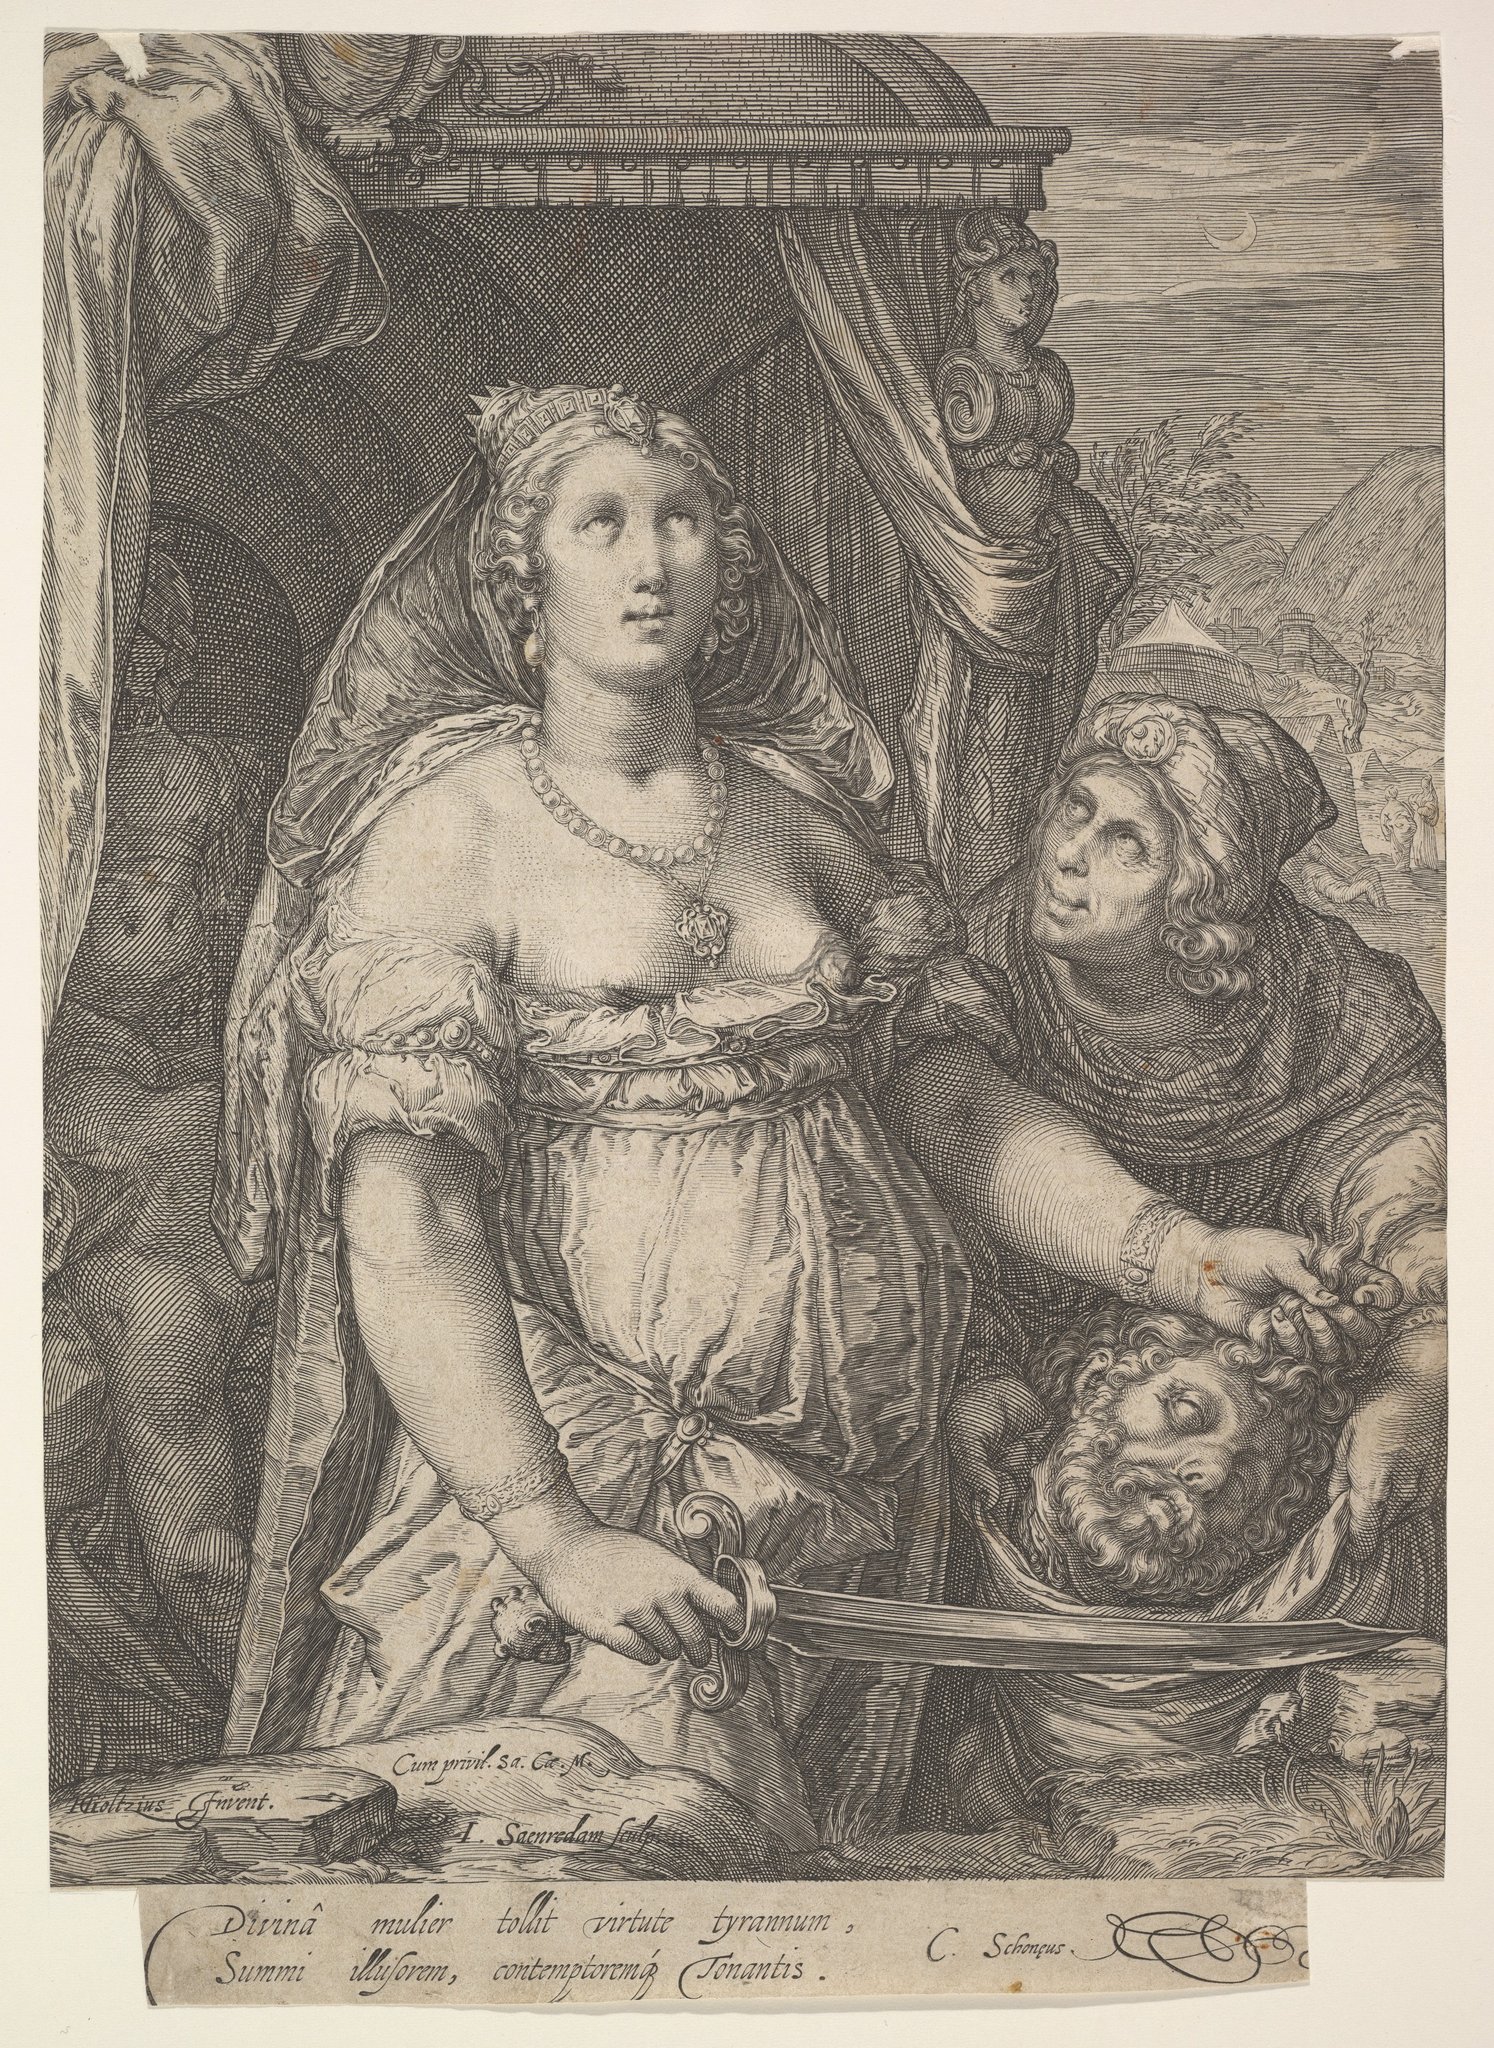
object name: print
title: Judith and the Head of Holofernes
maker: jan saenredam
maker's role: artist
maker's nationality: netherlandish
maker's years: 1565-1607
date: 1575-1607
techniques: engraving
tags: swords,heads,holofernes,judith